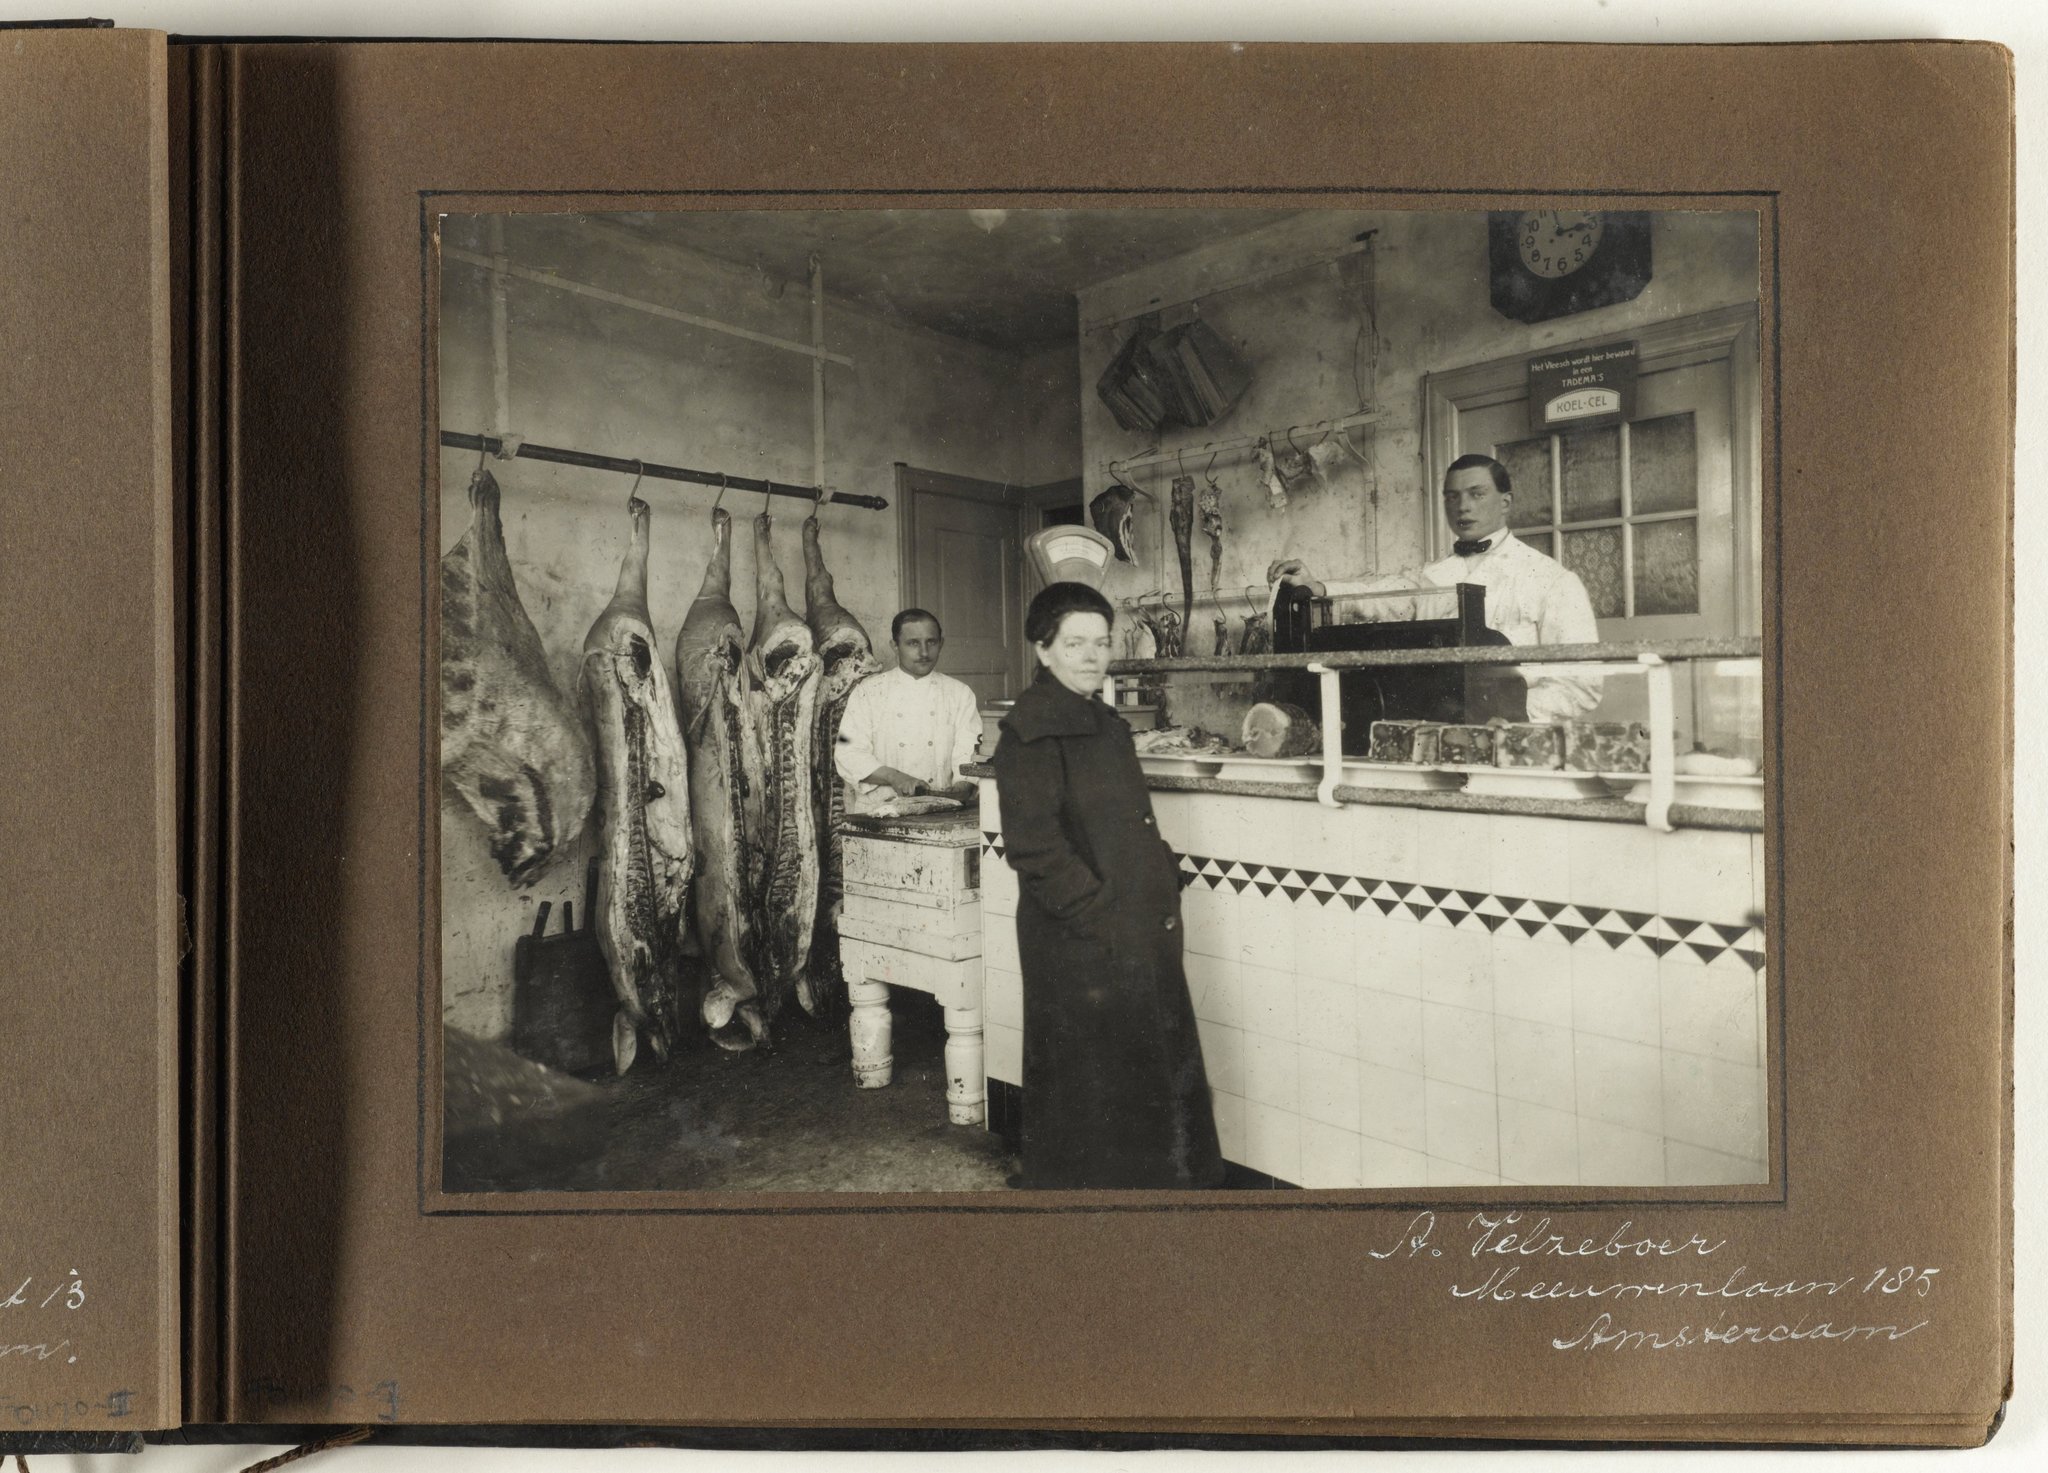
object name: album leaf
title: Interieur van de slagerij van A. Velzeboer, Meeuwenlaan 185, Amsterdam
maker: Anonymous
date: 1925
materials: paper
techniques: gelatin silver print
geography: amsterdam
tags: counter ~ shop, butcher, slaughterman, amsterdam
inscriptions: annotation: ‘A. Velzeboer/ Meeuwenlaan 185/ Amsterdam’